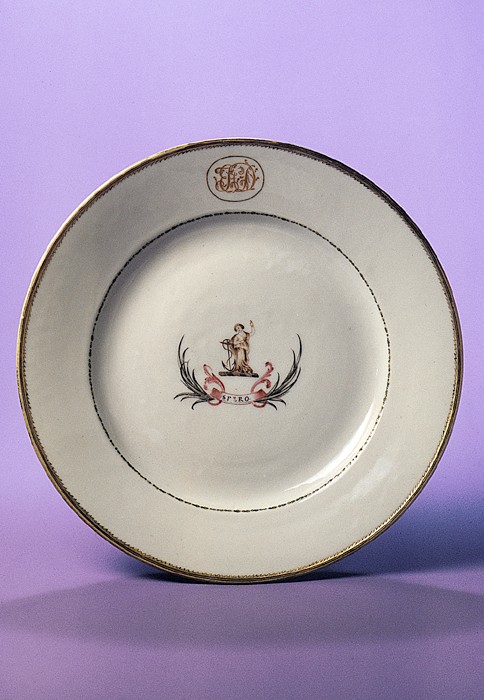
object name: plate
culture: chinese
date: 1786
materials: porcelain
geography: china